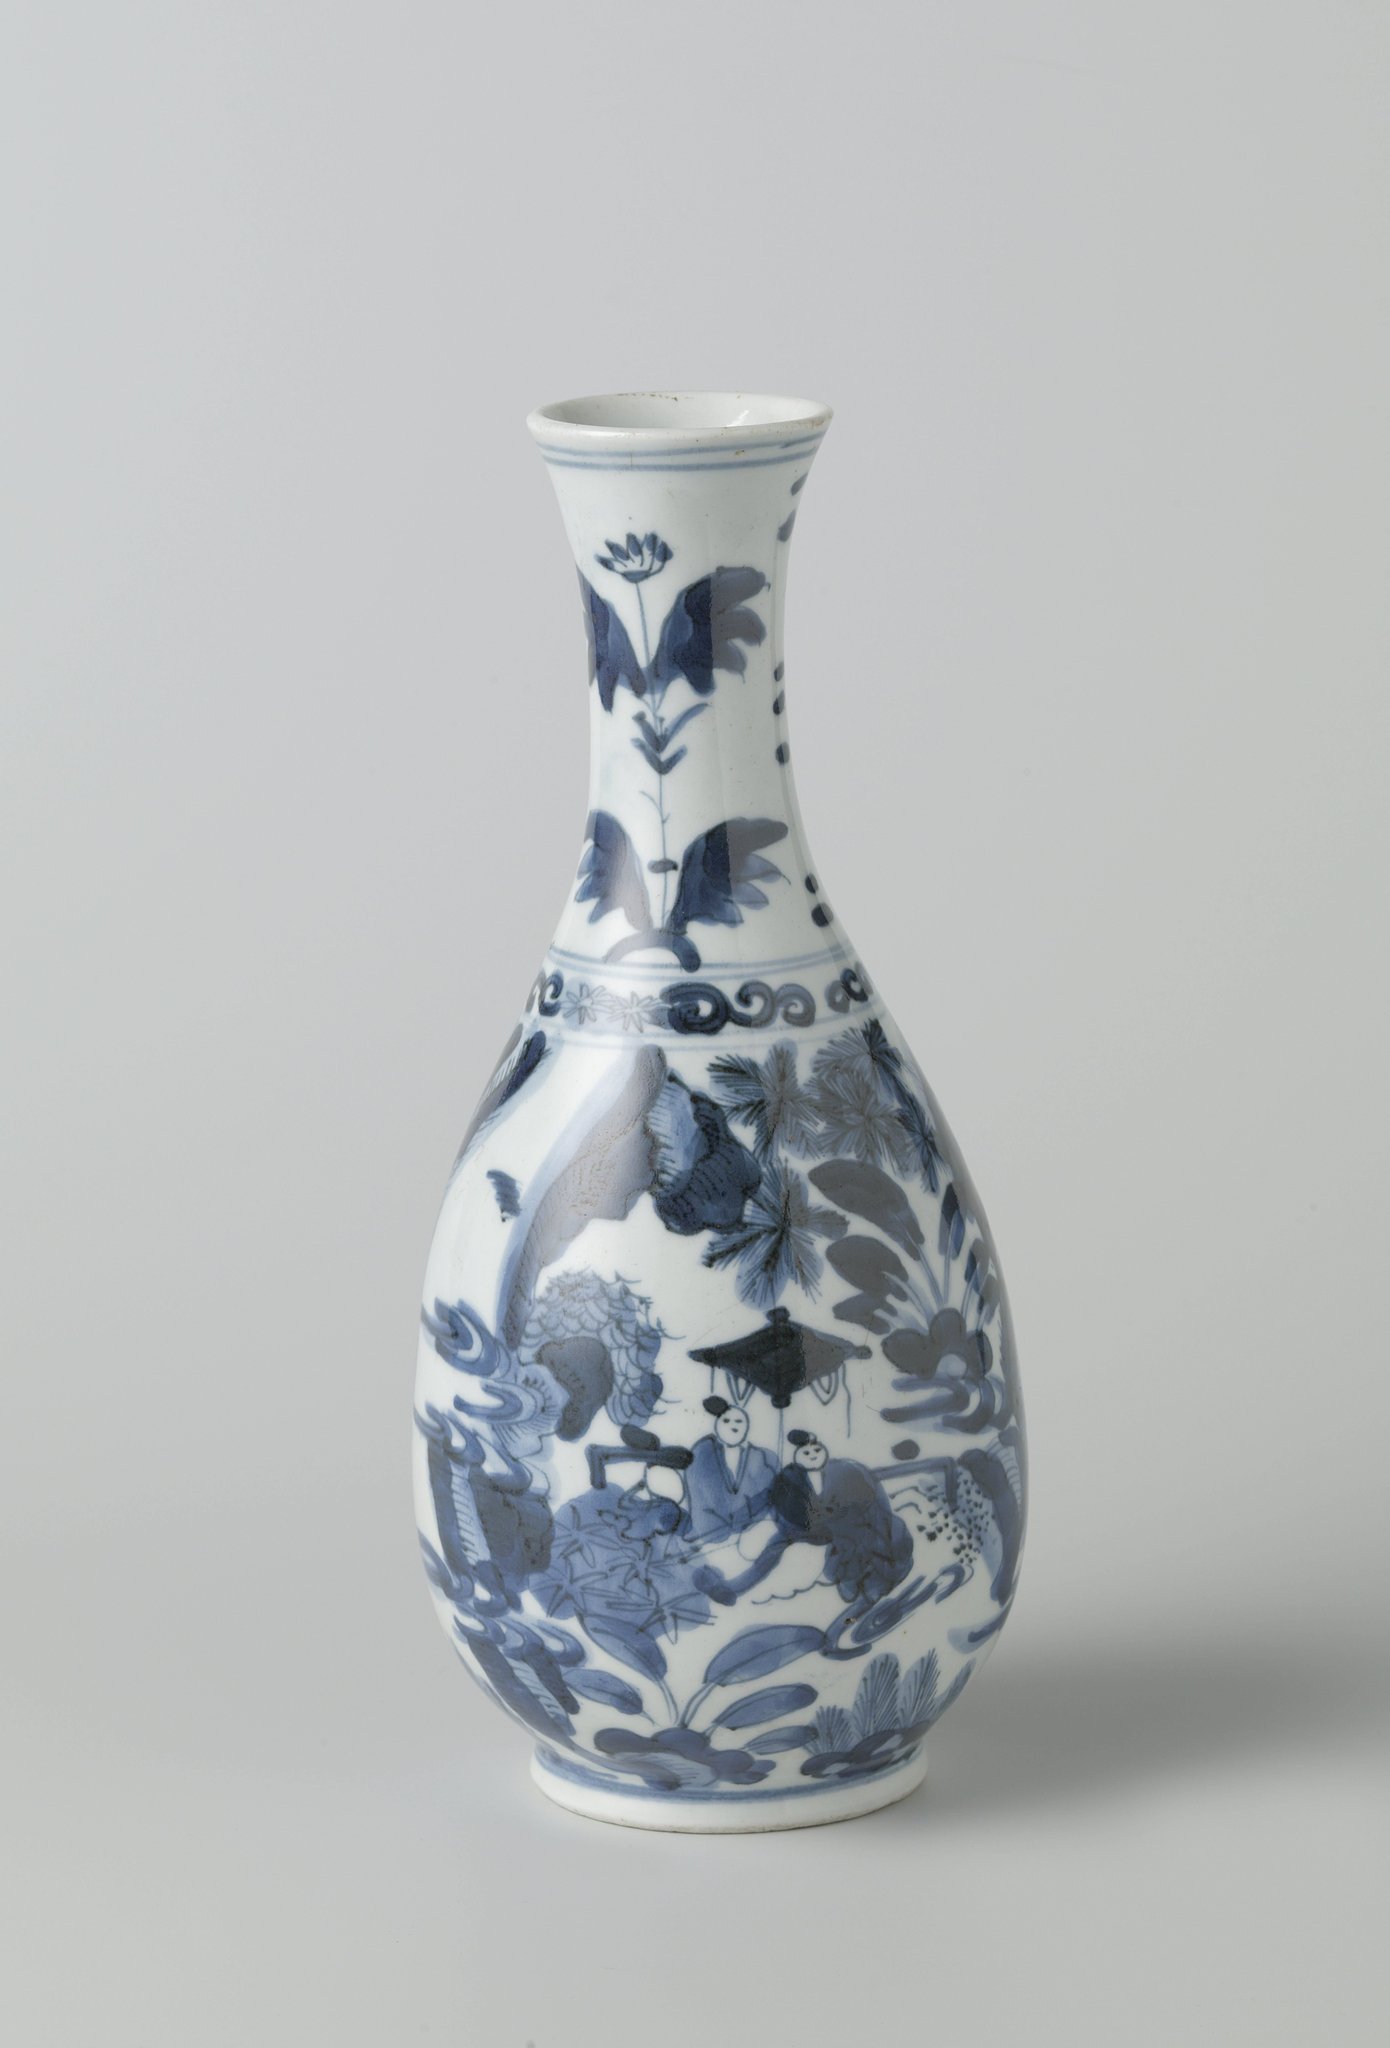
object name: bottle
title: Bottle with figures in a landscape, floral scrolls and tulip motifs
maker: Anonymous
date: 1655-1680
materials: cobalt, glaze, paint, porcelain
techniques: firing, turning, vitrification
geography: arita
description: Fles van porselein met peervormig lichaam en spreidende hals, beschilderd in onderglazuur blauw. Op de buik een doorlopende voorstelling met mensen in een landschap. Op de schouder een band met bloemranken. De nek met drie keer een tulpmotief. Arita, blauw-wit.